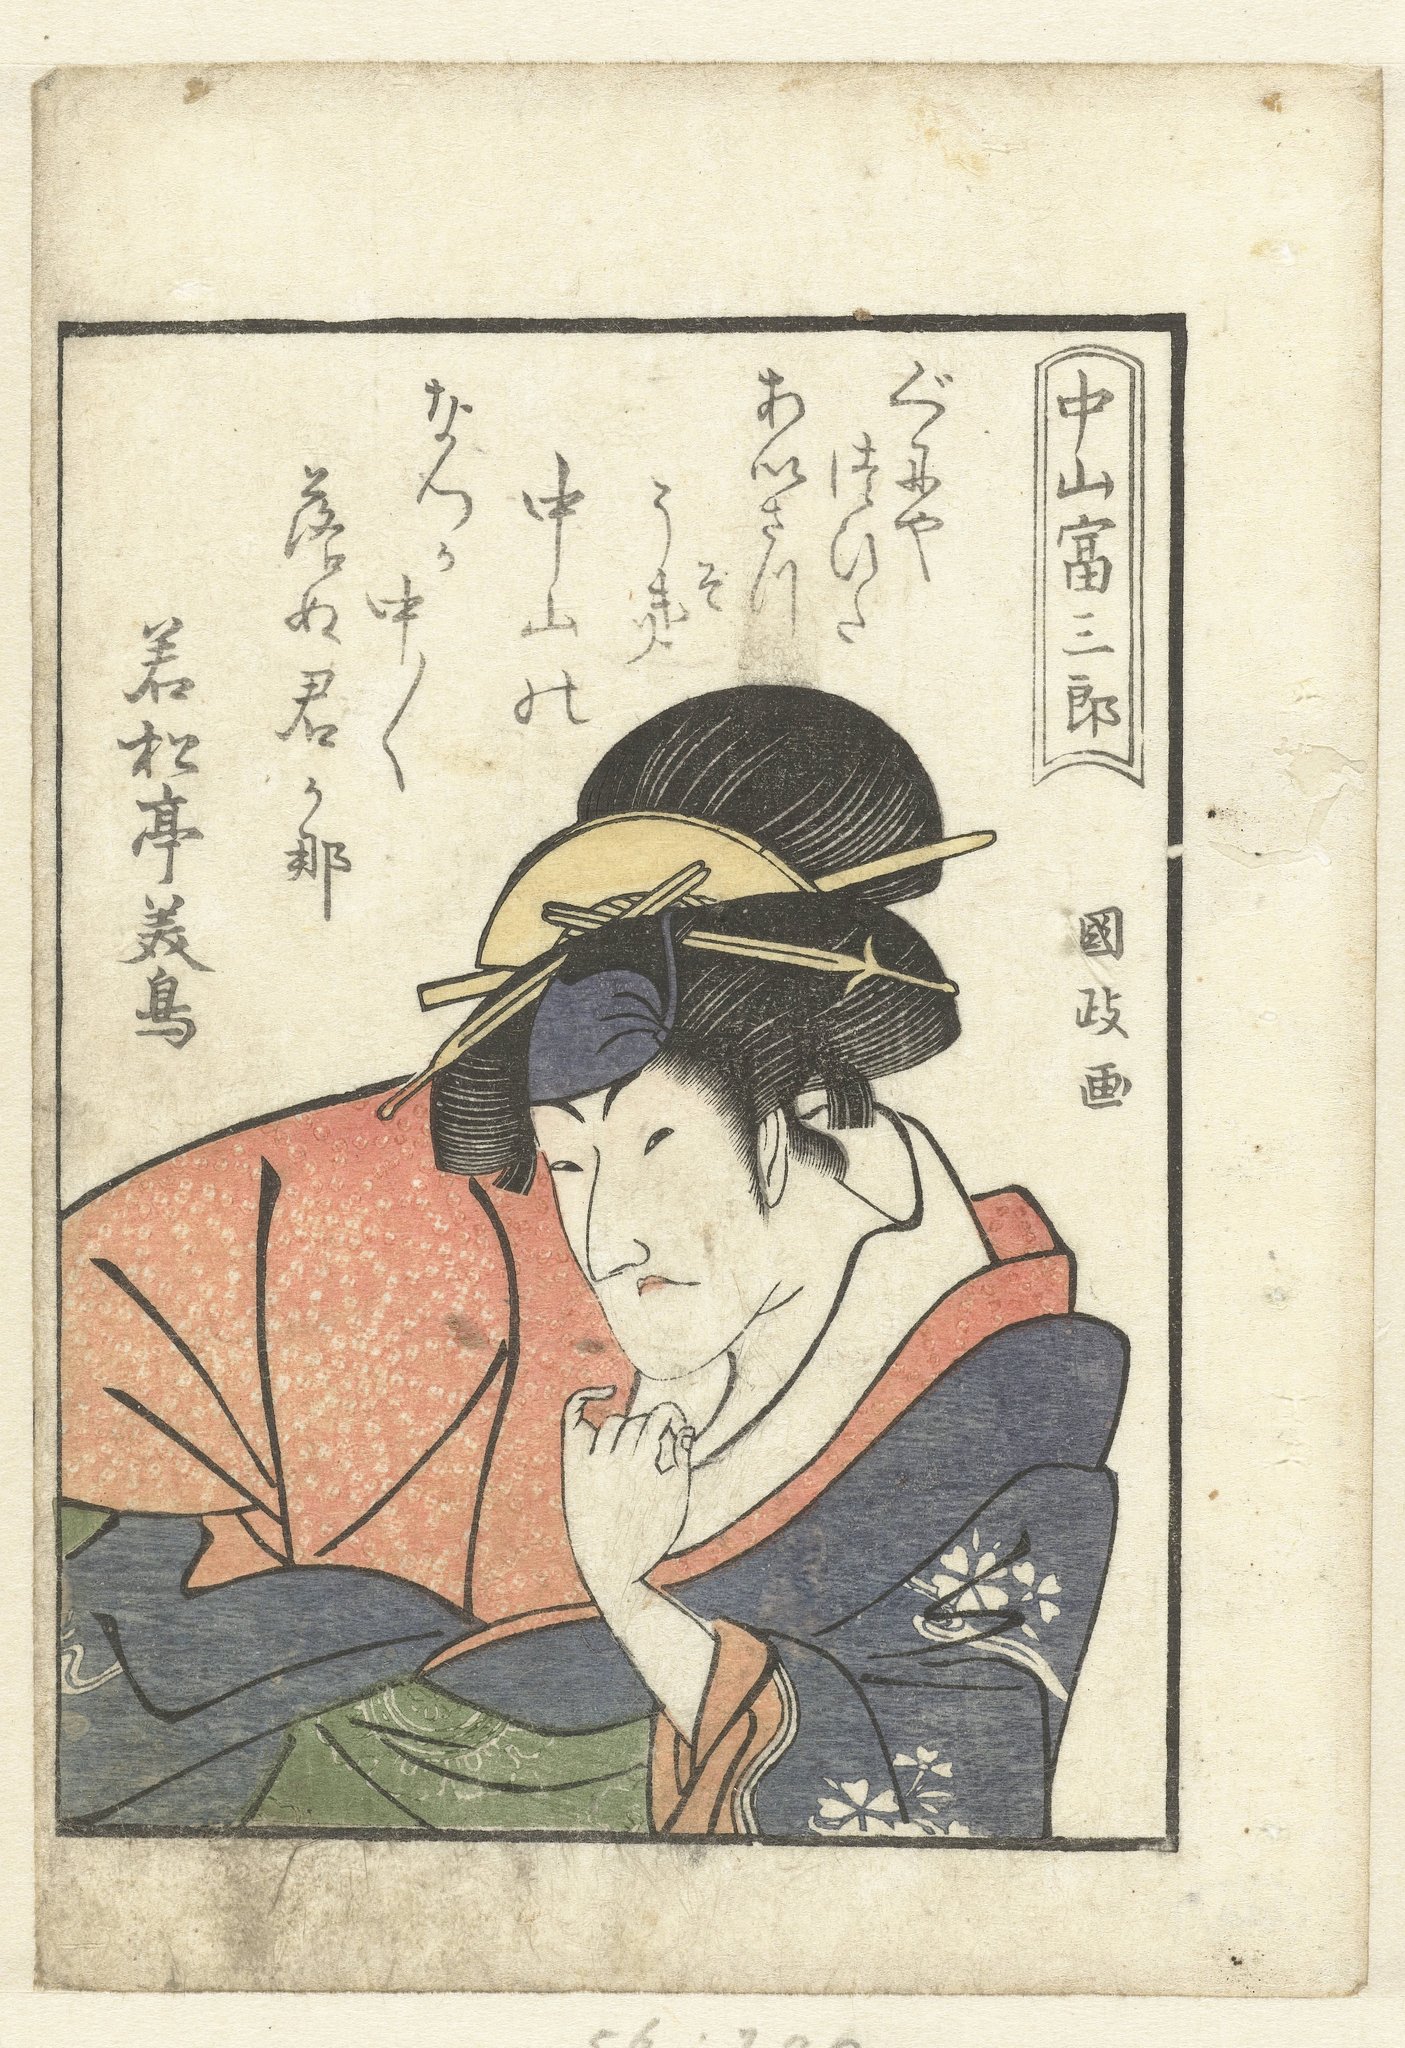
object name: print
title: Een kijkje achter de schermen bij de toneelspelers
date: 1799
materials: paper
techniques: woodcut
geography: edo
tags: portrait of actor, actress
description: Busteportret van de acteur Nakayama Tomisaburo I, in vrouwenrol met rode en blauwe kimono en groene obi, afgebeeld onder een aan hem gericht liefdesgedicht. Blad uit het Japanse boek Yakusha gakuya tsu.